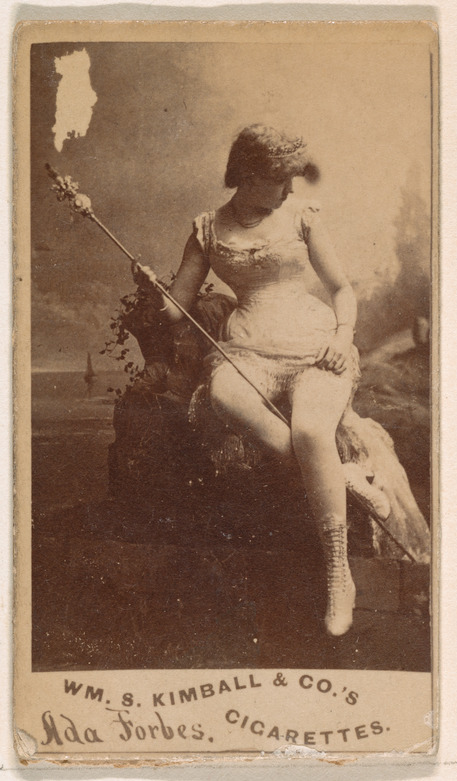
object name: photograph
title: Ada Forbes, from the Actresses series (N203) issued by Wm. S. Kimball & Co.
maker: william s. kimball & company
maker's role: publisher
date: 1889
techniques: color lithograph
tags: women,actresses